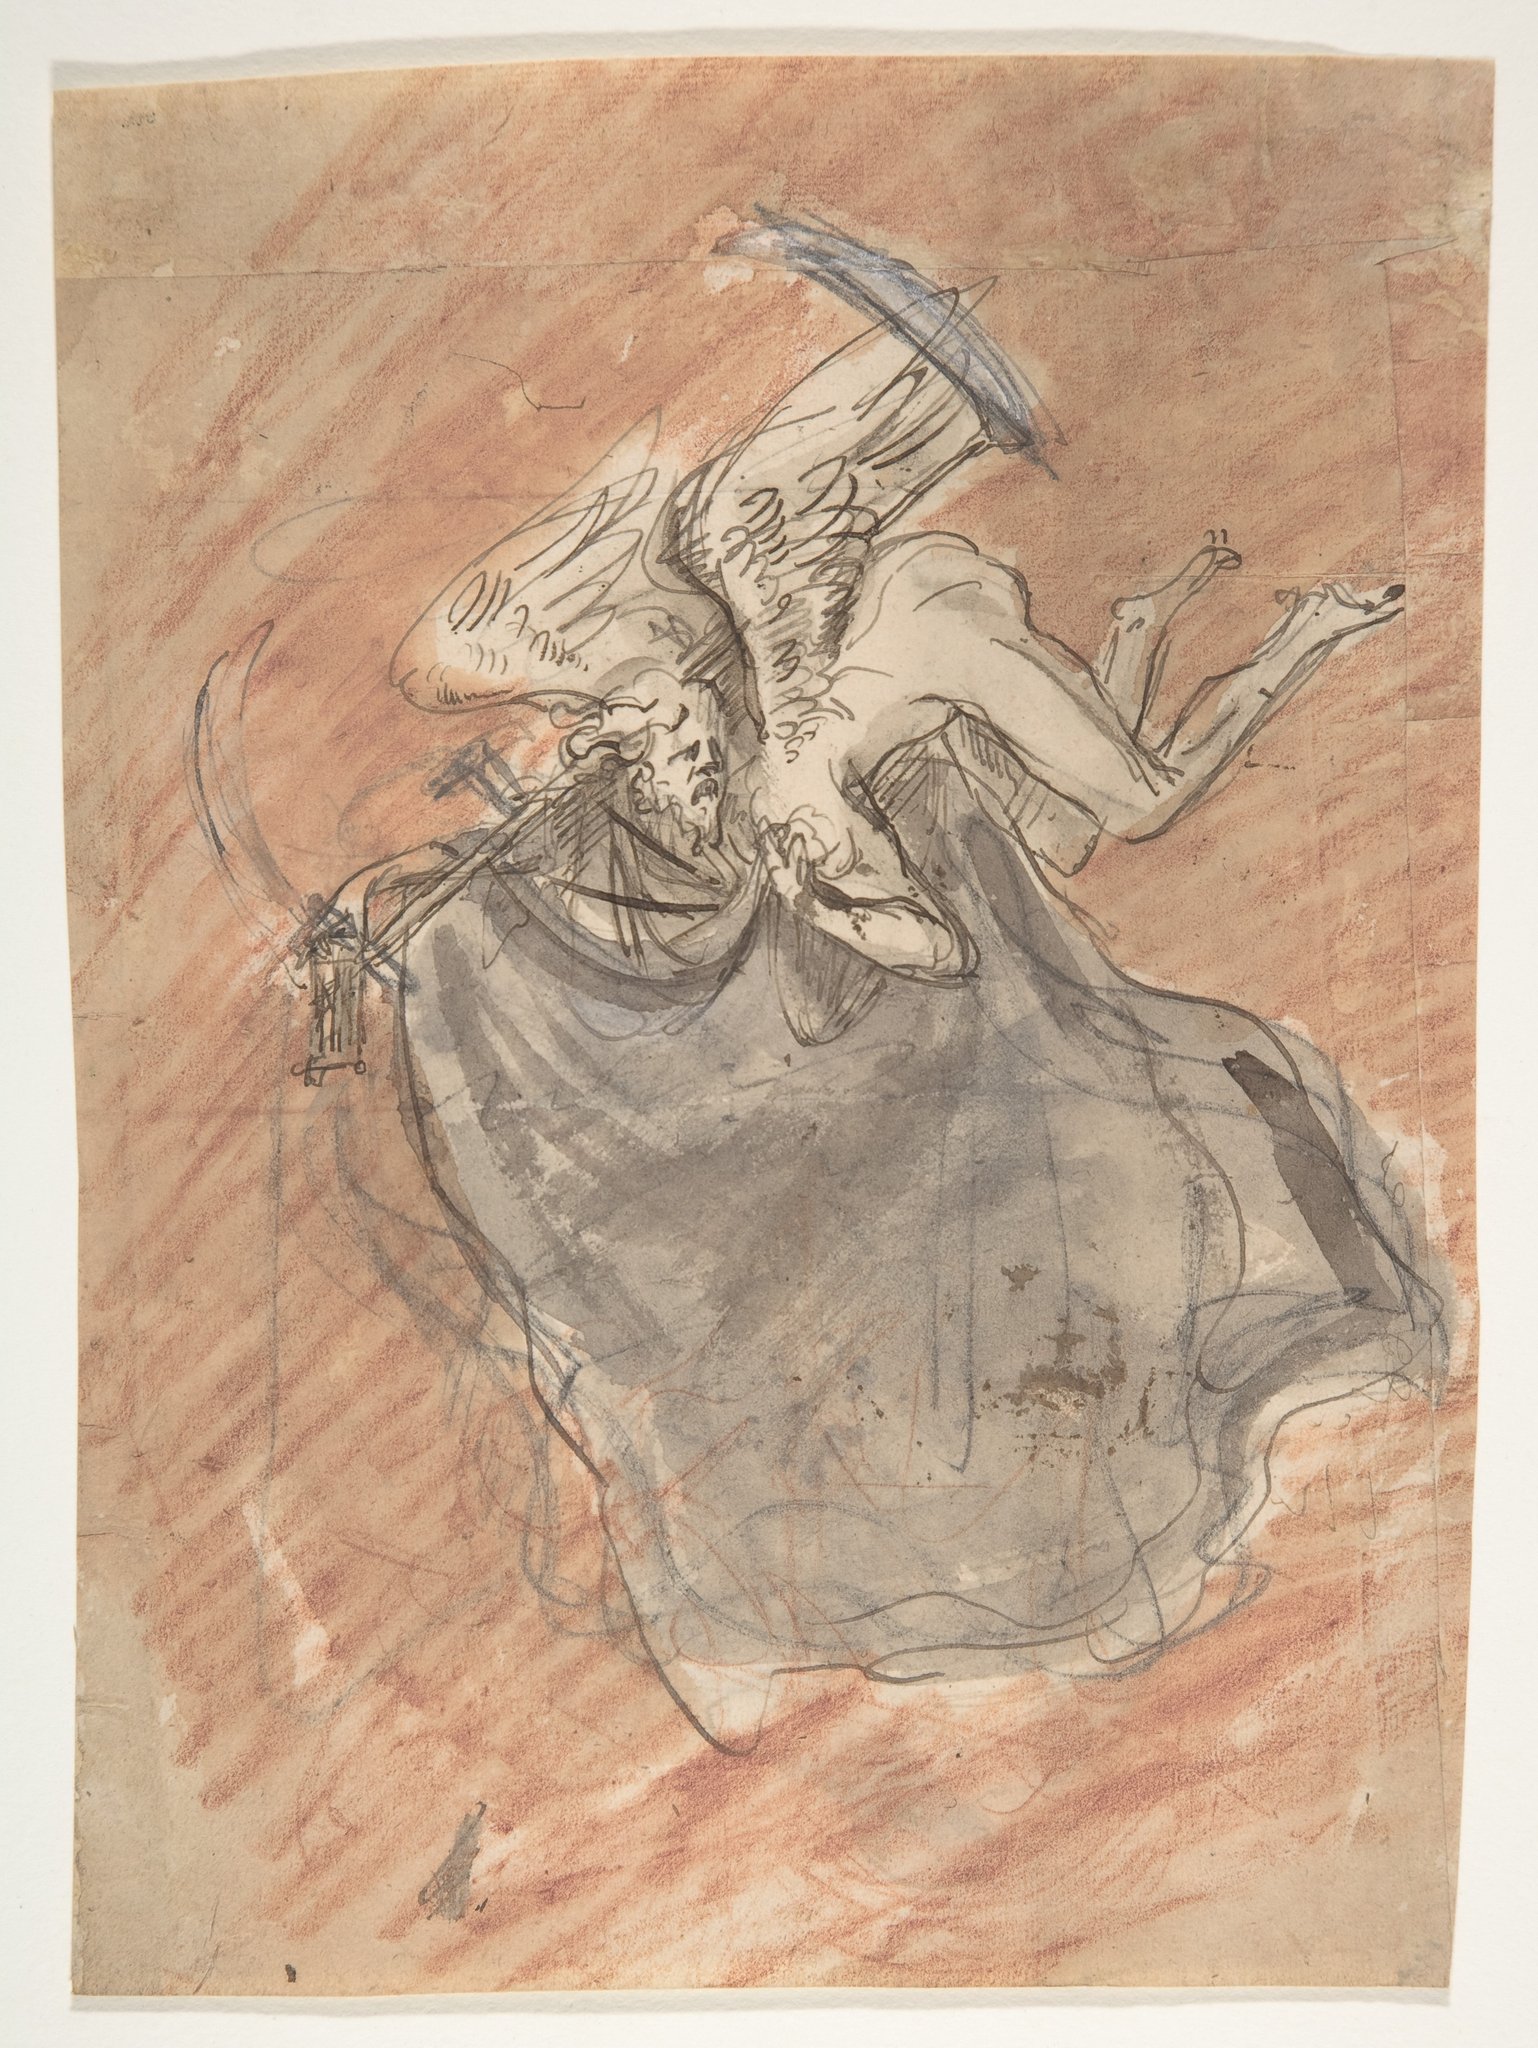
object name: drawing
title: Design for a sepulchral monument with an allegory of Time (recto); Design for a sepulchral monument (verso)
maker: pieter verbruggen the younger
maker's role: artist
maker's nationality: flemish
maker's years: 1648-1691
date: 1667-1733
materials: chalk, graphite, ink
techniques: pen, wash